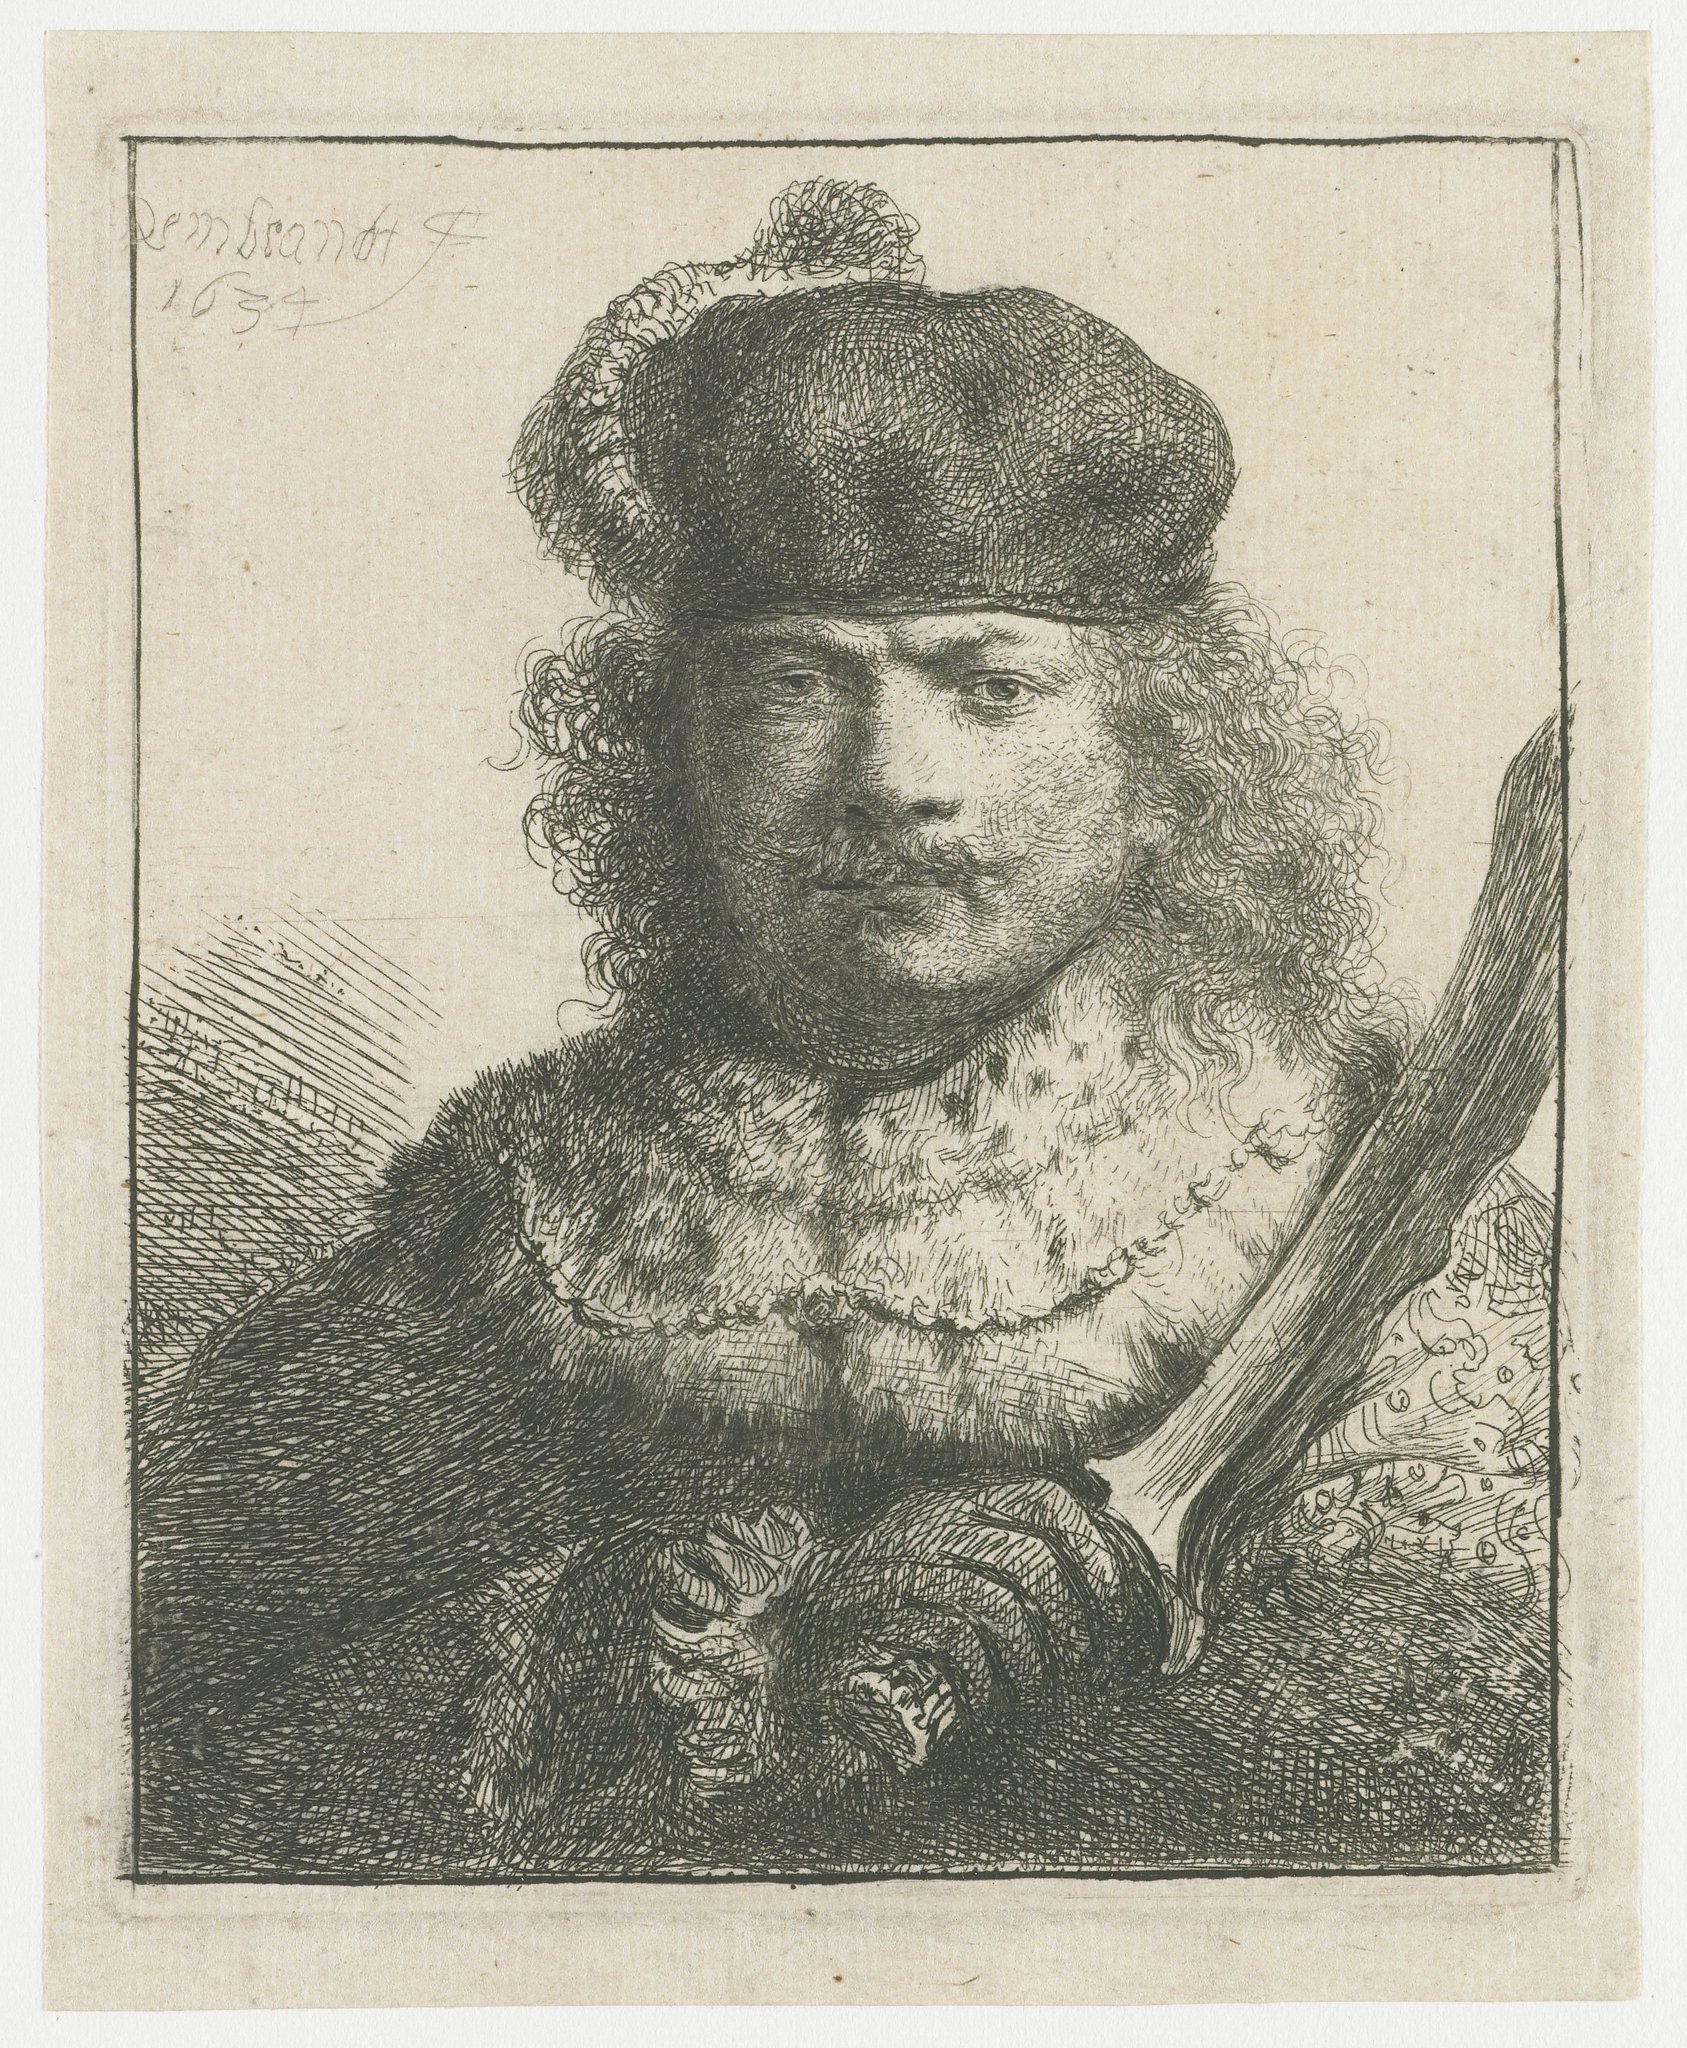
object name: print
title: Self-portrait with raised sabre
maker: rembrandt van rijn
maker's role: draughtsman, painter, print maker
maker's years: 1606-1669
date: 1634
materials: paper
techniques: etching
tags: leiden, amsterdam, print maker, draughtsman, rembrandt van rijn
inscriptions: collector's mark: Lugt 119, collector's mark: Lugt 2005, collector's mark: Lugt 152 a, collector's mark: Lugt 2228, signature and date: ‘Rembrandt f. 1634’